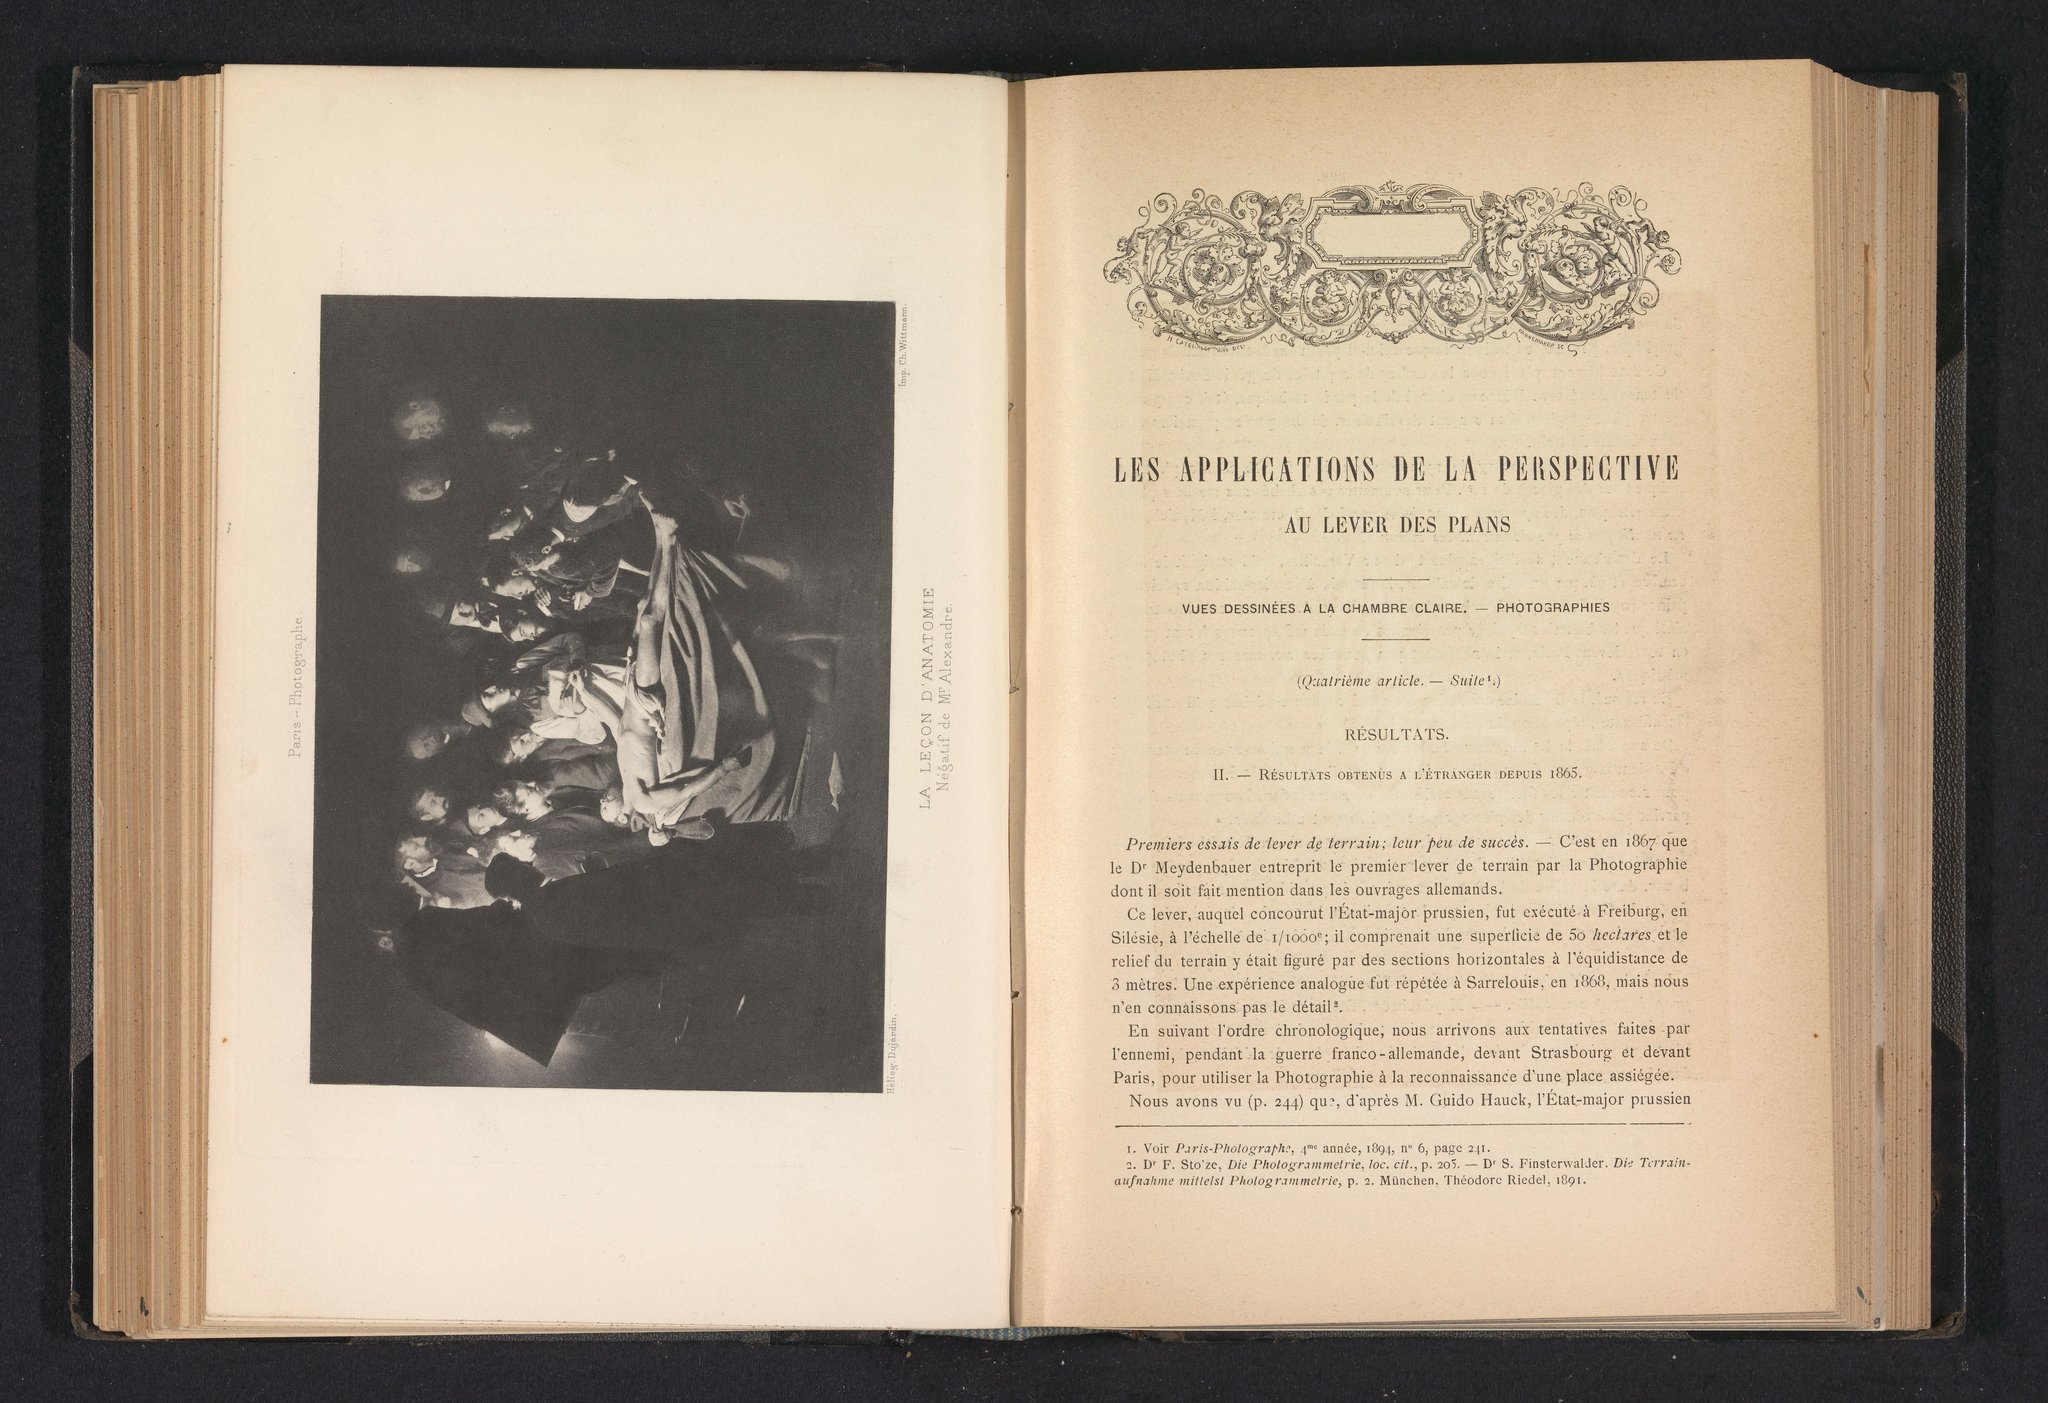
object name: page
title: Le leçon d'anatomie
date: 1884-1894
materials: paper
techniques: photoaquatint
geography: france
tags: anatomical specimen